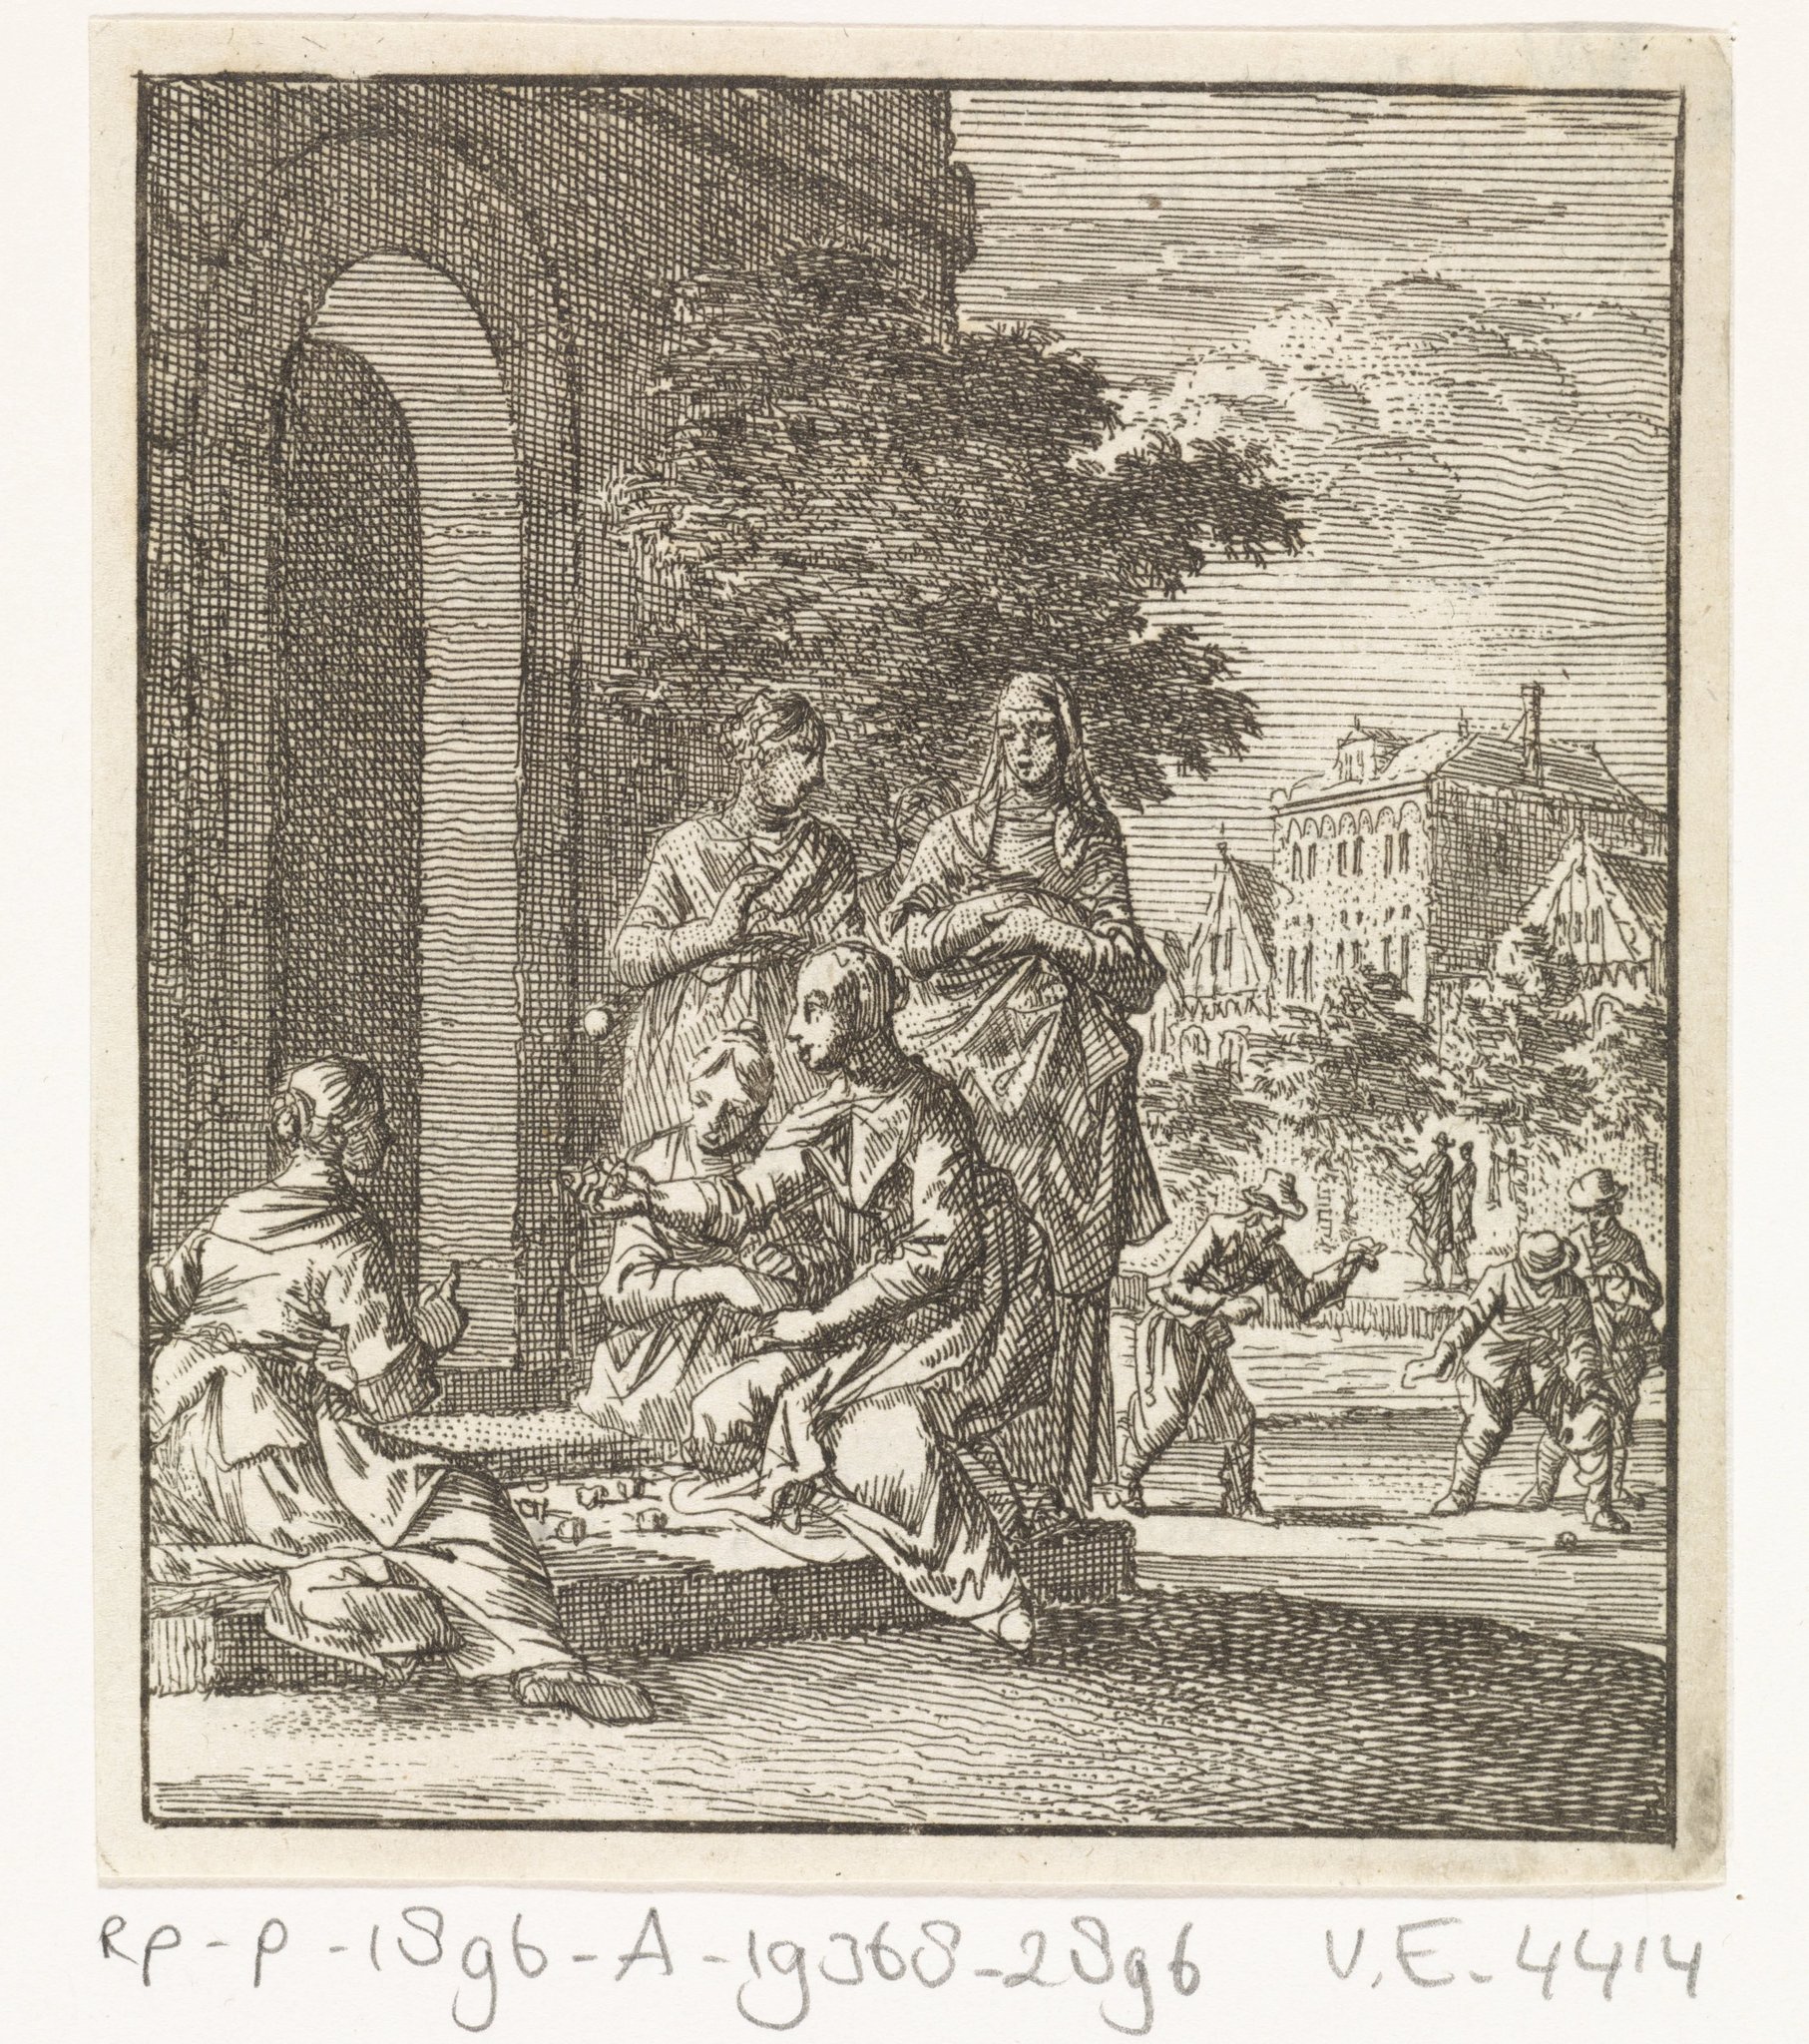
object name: print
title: De Bikkel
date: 1712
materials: paper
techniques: etching, letterpress printing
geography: amsterdam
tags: children's games and plays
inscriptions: collector's mark: Lugt 2228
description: Illustratie uit: Luyken, Jan. Des menschen begin, midden en einde. Amsterdam: Wed. Pieter Arentsz II en Cornelis van der Sys, 1712, p. 55.